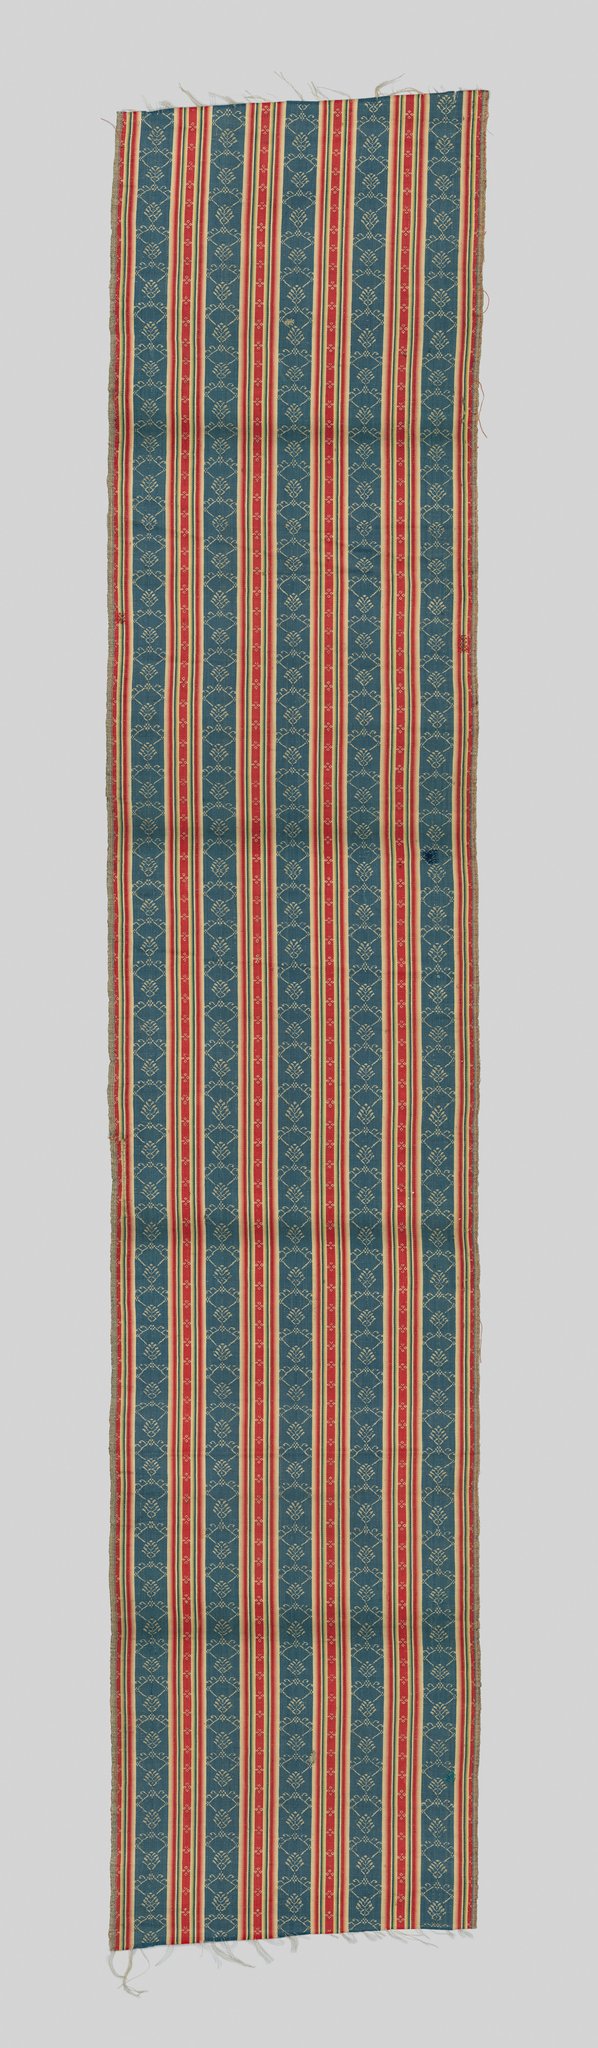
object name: length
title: Length of wool Calimanco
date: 1750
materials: wool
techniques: weave